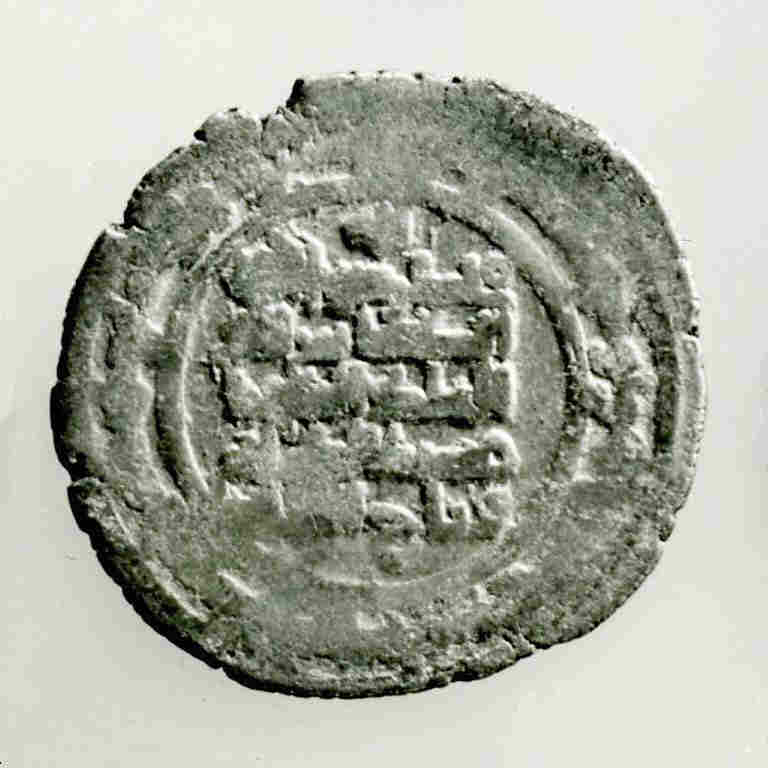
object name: coin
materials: silver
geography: iran